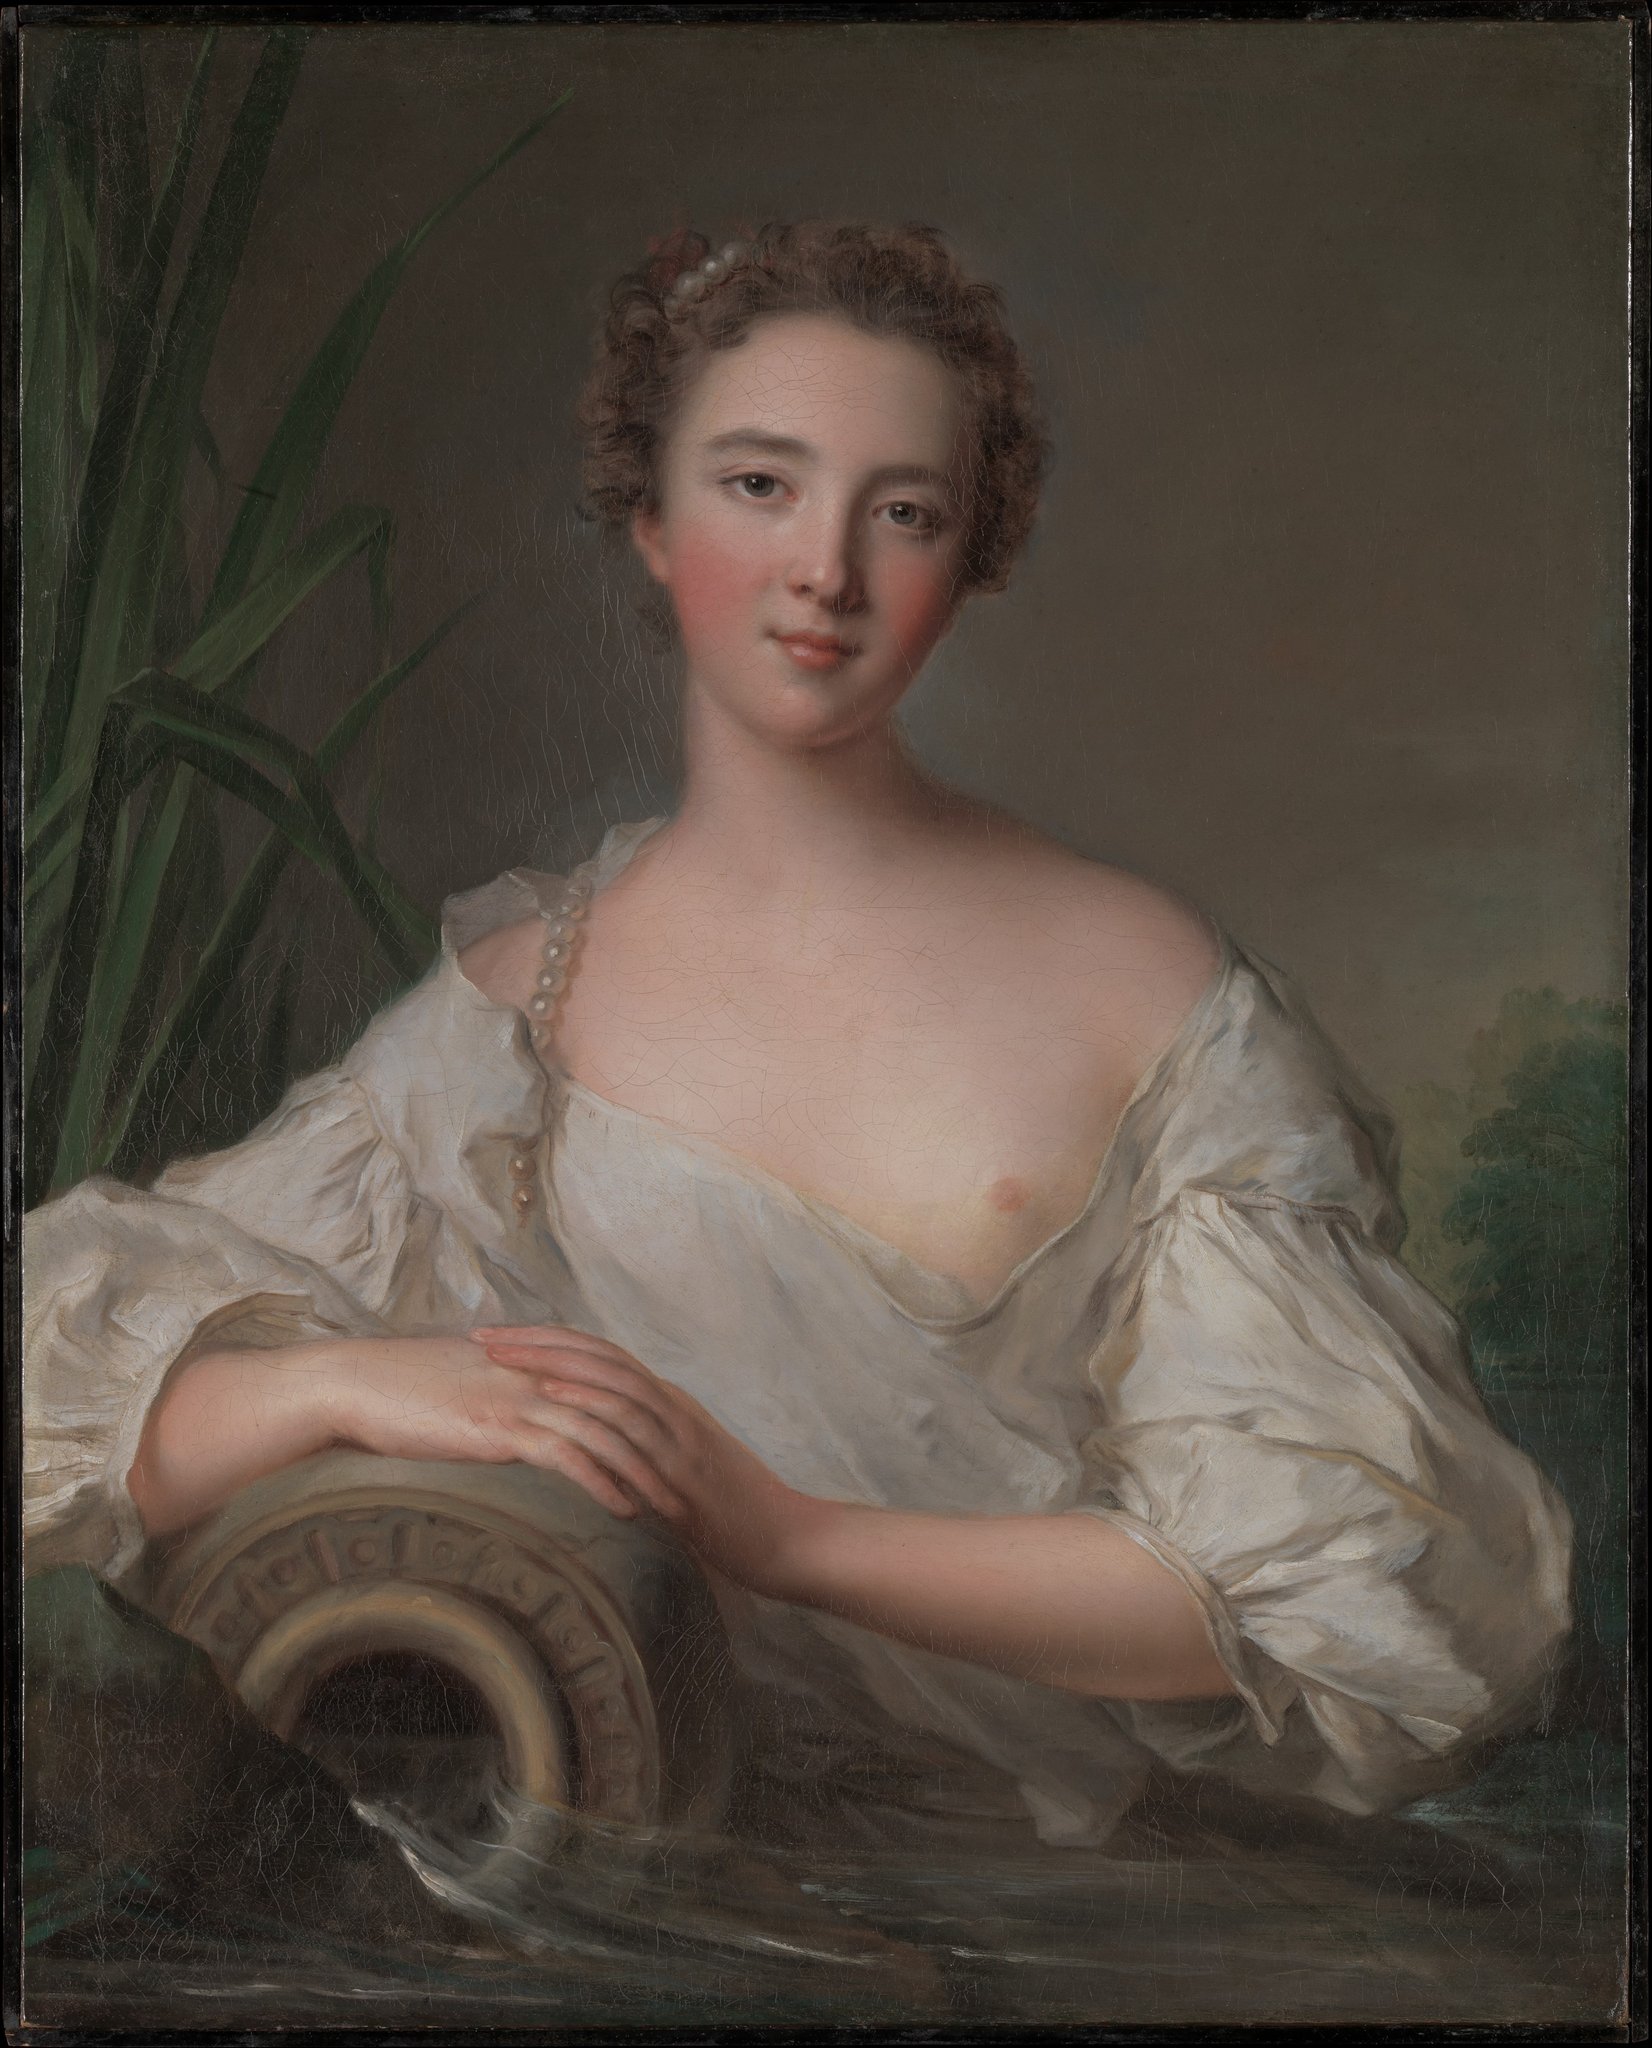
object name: painting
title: The Spring (La Source)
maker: jean marc nattier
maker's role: artist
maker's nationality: french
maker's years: 1685-1766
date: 1738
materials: canvas, oil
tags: portraits,female nudes